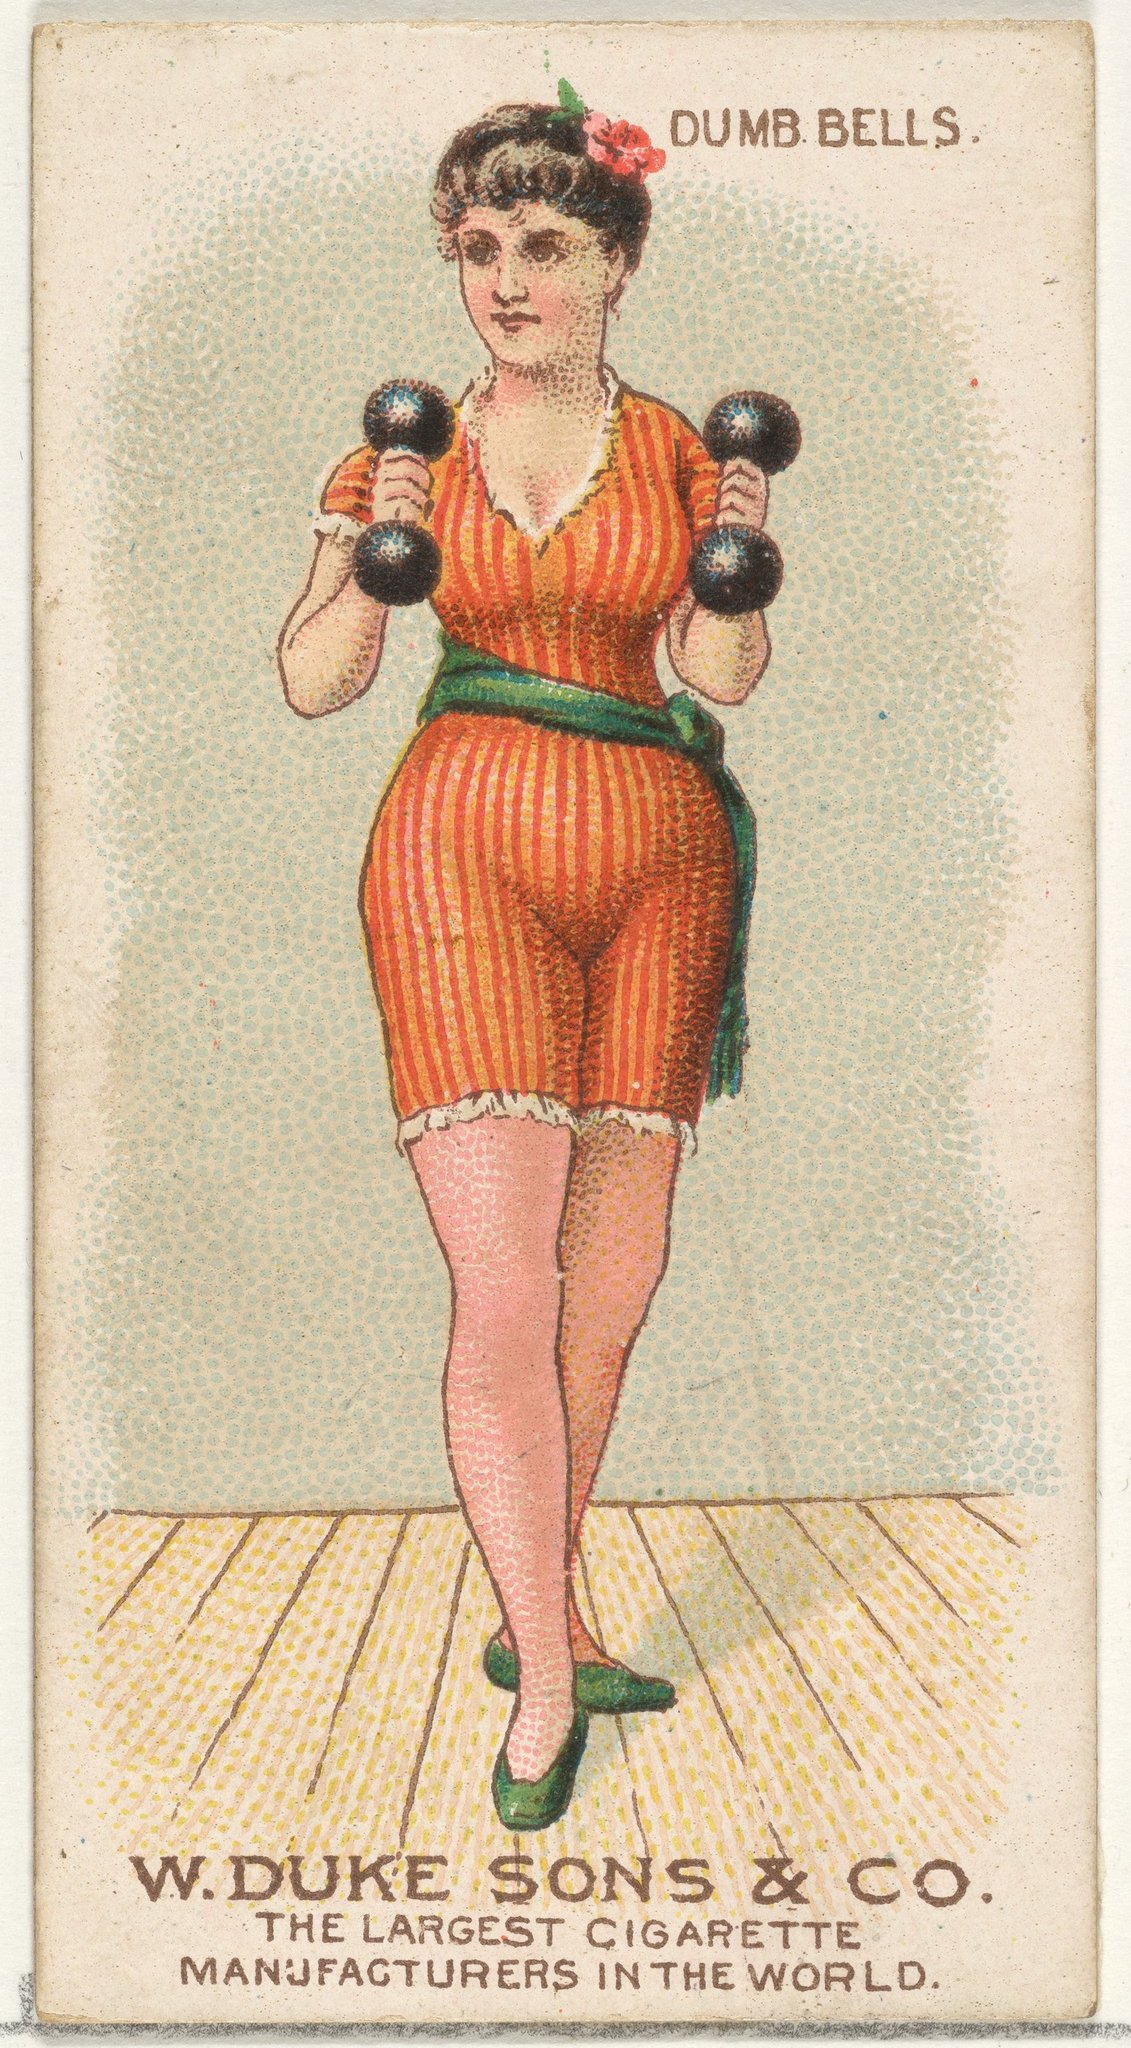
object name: print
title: Dumb Bells, from the Gymnastic Exercises series (N77) for Duke brand cigarettes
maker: w. duke, sons & co.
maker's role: publisher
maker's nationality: american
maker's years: 1870-1920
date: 1887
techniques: color lithograph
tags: women,athletes